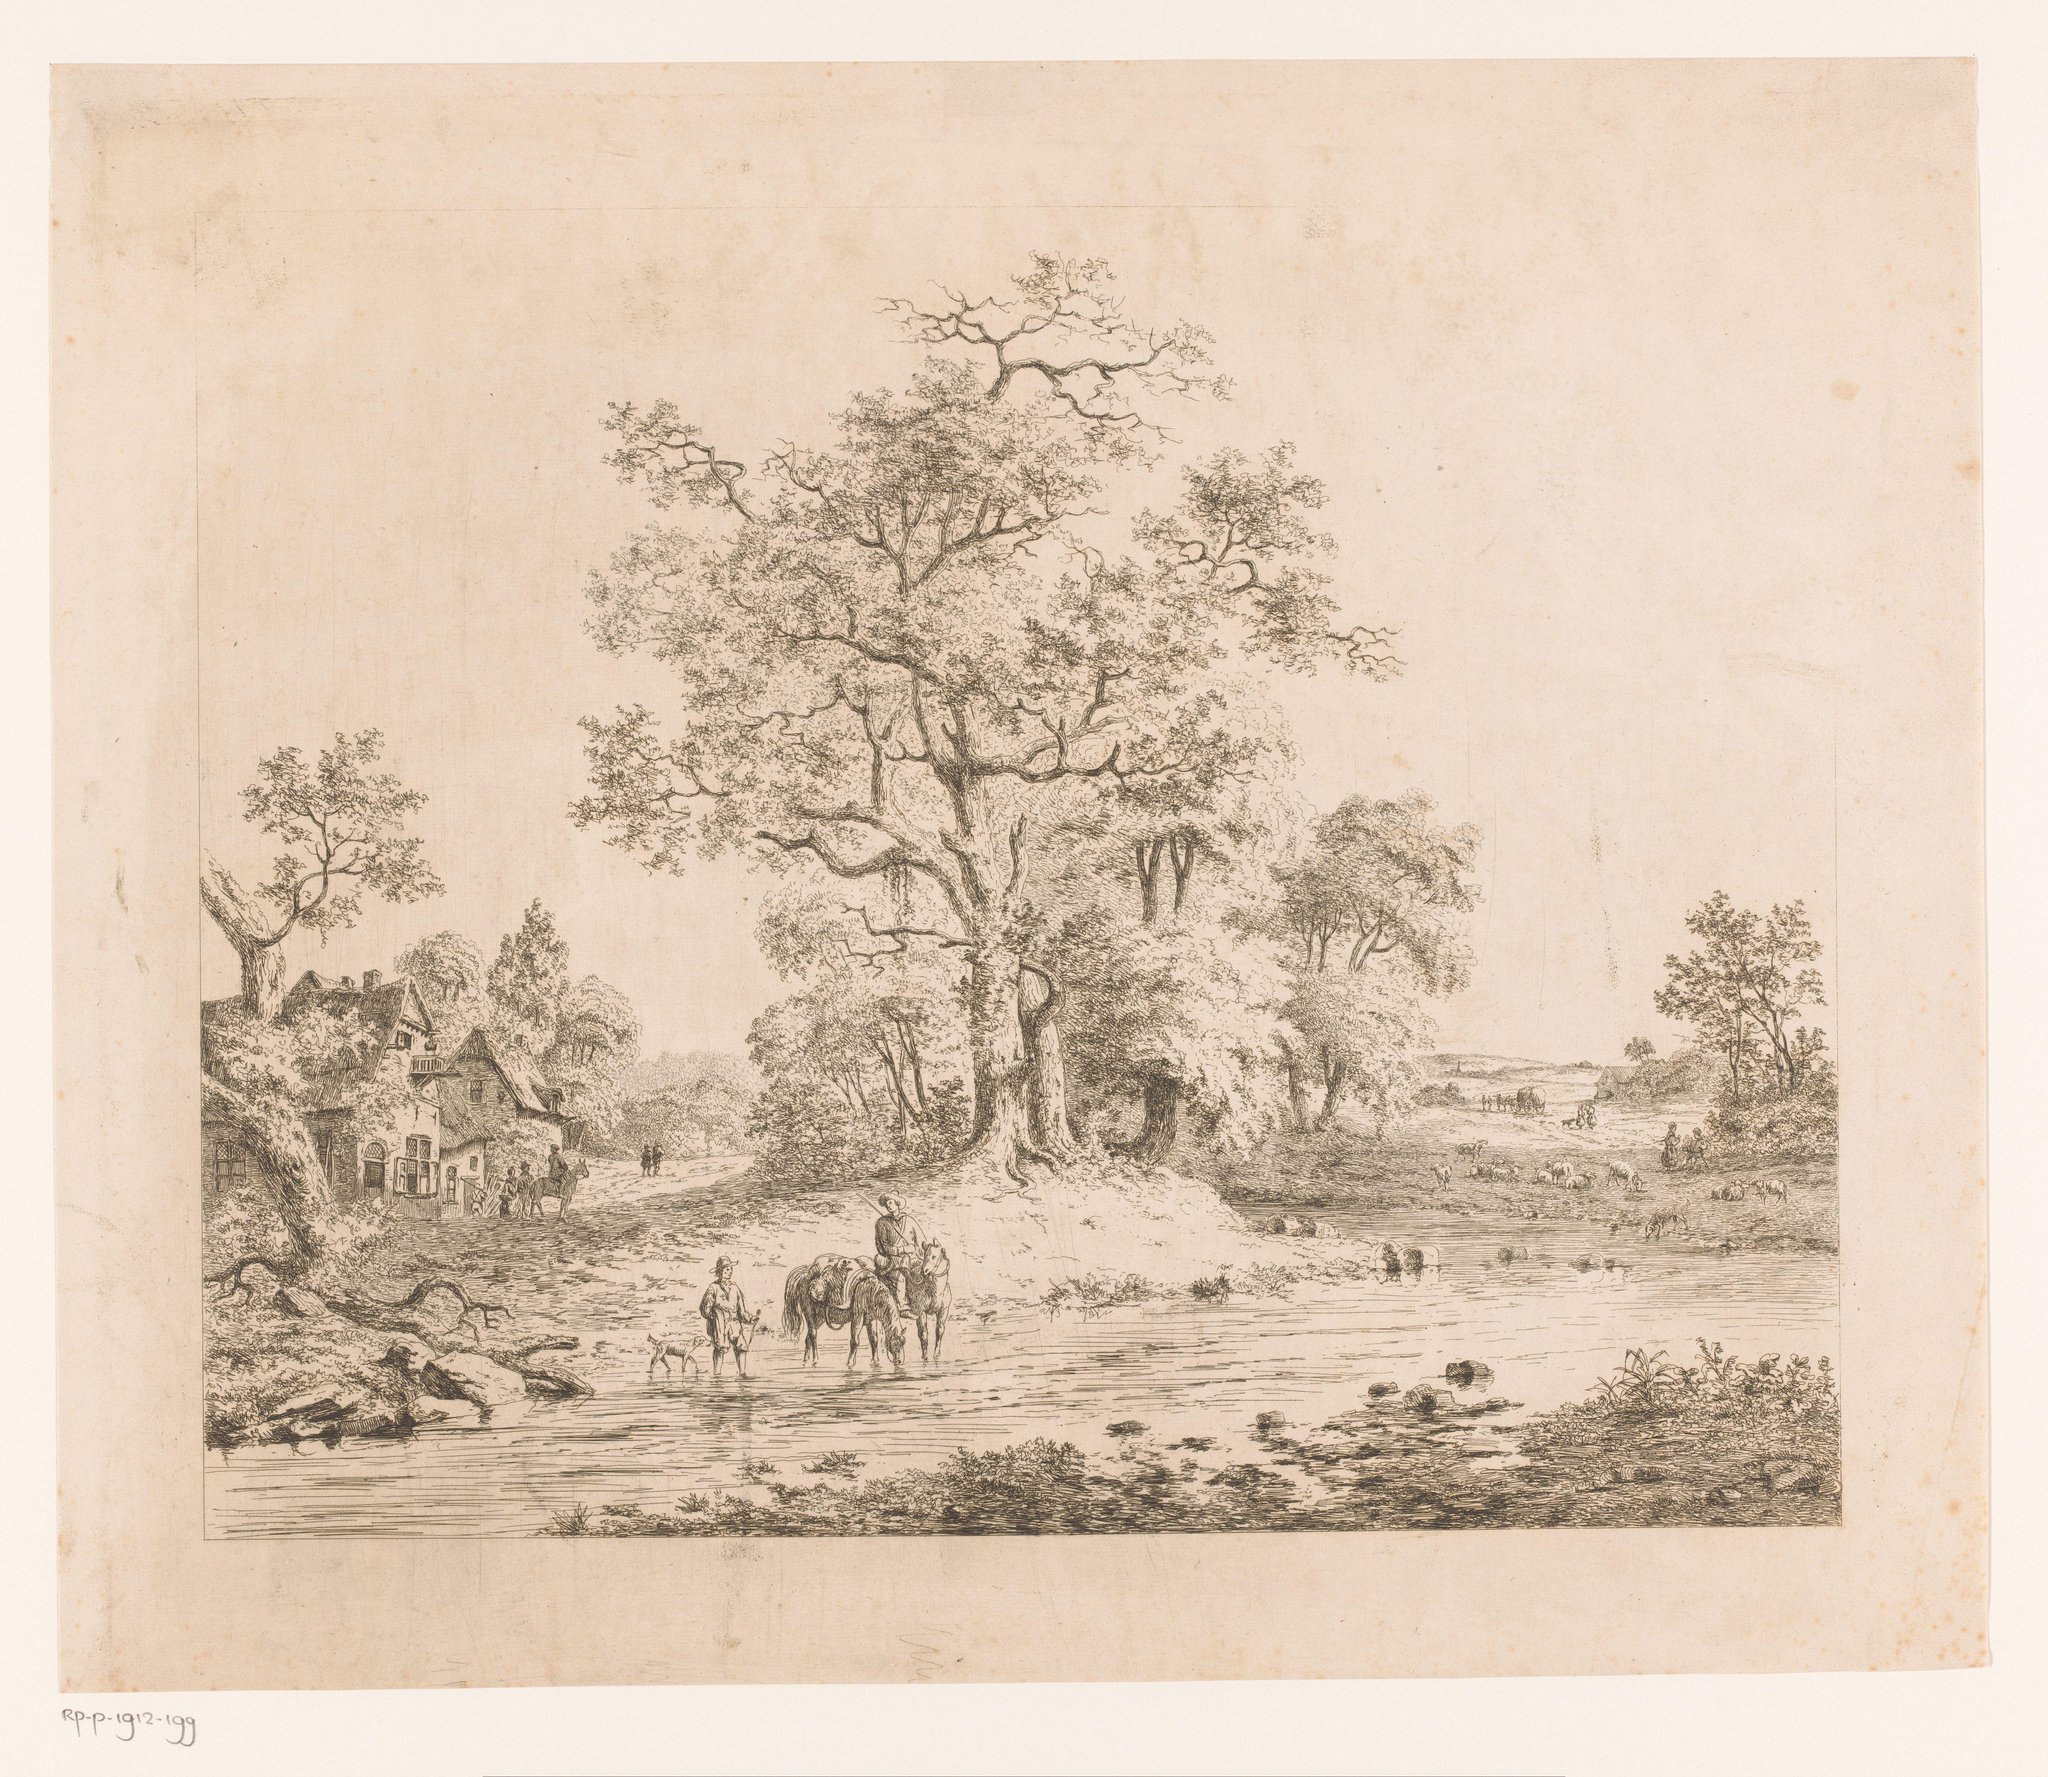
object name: print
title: Landschap langs de Samber, een ruiter met twee paarden in het water naast een man met een hond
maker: jean théodore joseph linnig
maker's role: draughtsman, print maker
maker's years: 1815-1891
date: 1856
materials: paper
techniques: etching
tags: river (+ landscape with figures, staffage)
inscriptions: collector's mark: Lugt 1485, collector's mark: Lugt 2228